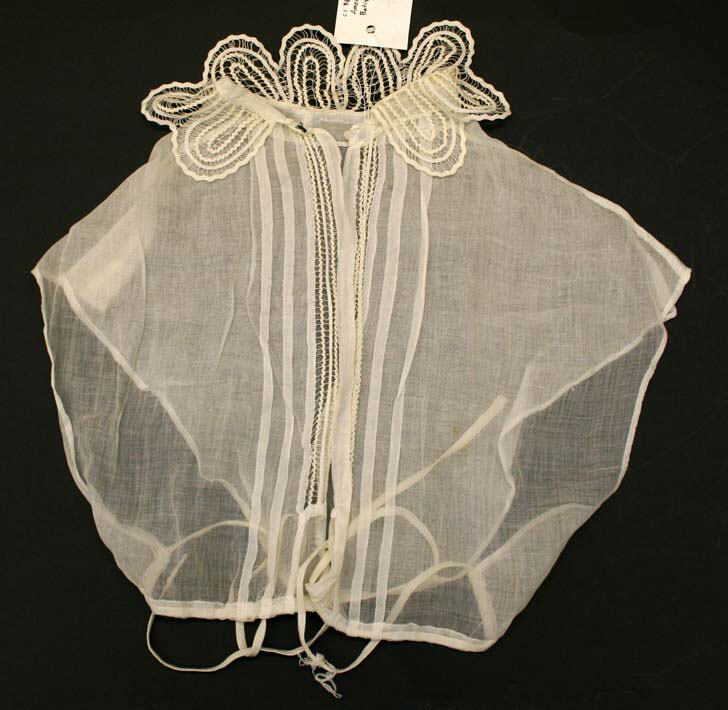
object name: vestee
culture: european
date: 1850-1859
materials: cotton